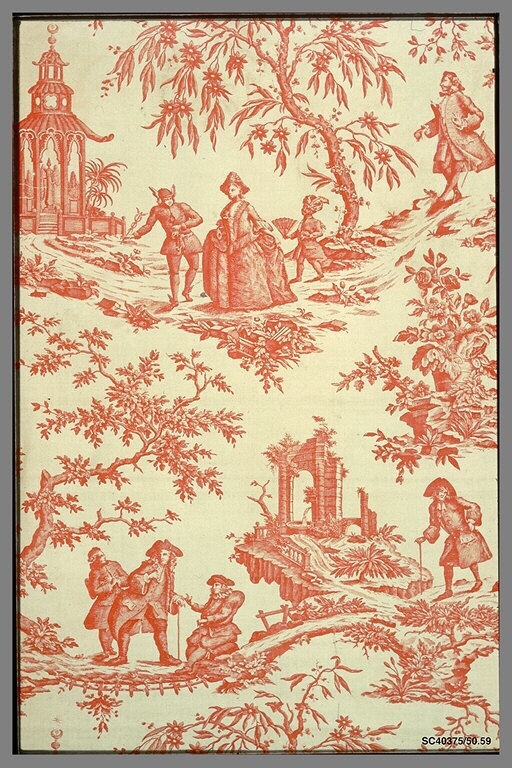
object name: piece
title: Scenes from "Lethe"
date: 1775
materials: copper, cotton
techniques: printing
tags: ruins,fans,men,women,trees